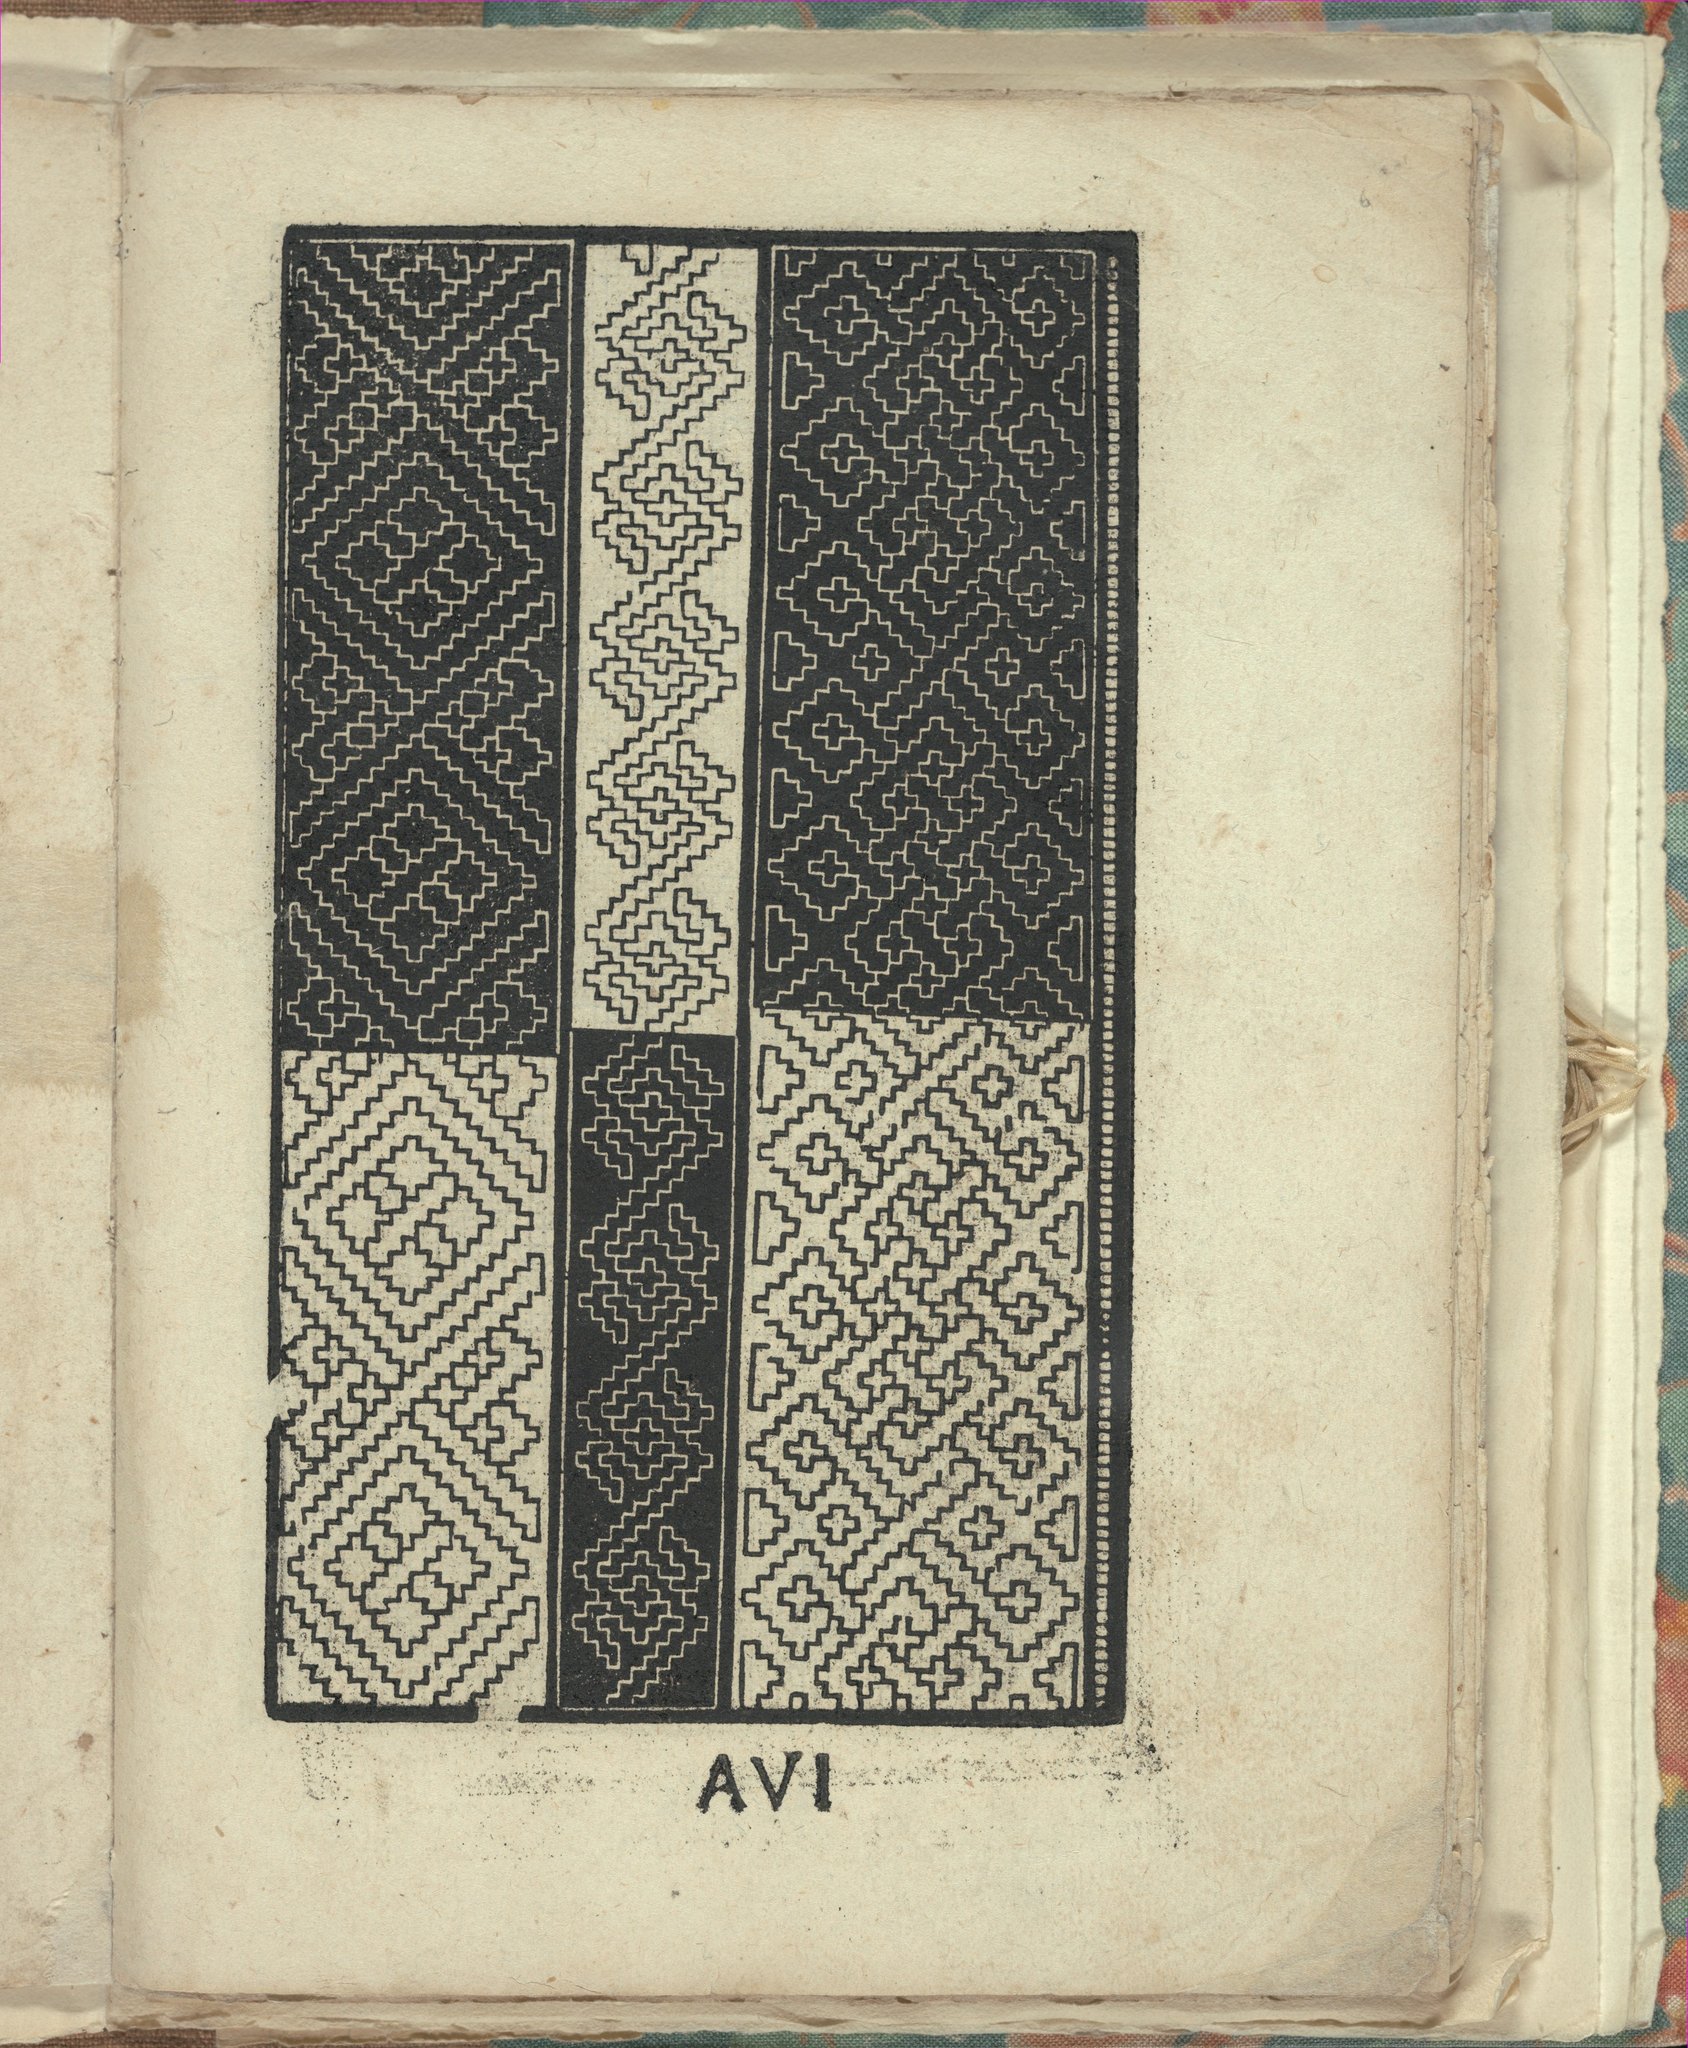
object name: book print ornament architecture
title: Opera Nova Universali intitulata Corona di racammi, page 6 (recto)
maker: giovanni andrea vavassore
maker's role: publisher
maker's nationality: italian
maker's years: 1530-1573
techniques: woodcut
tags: ornament